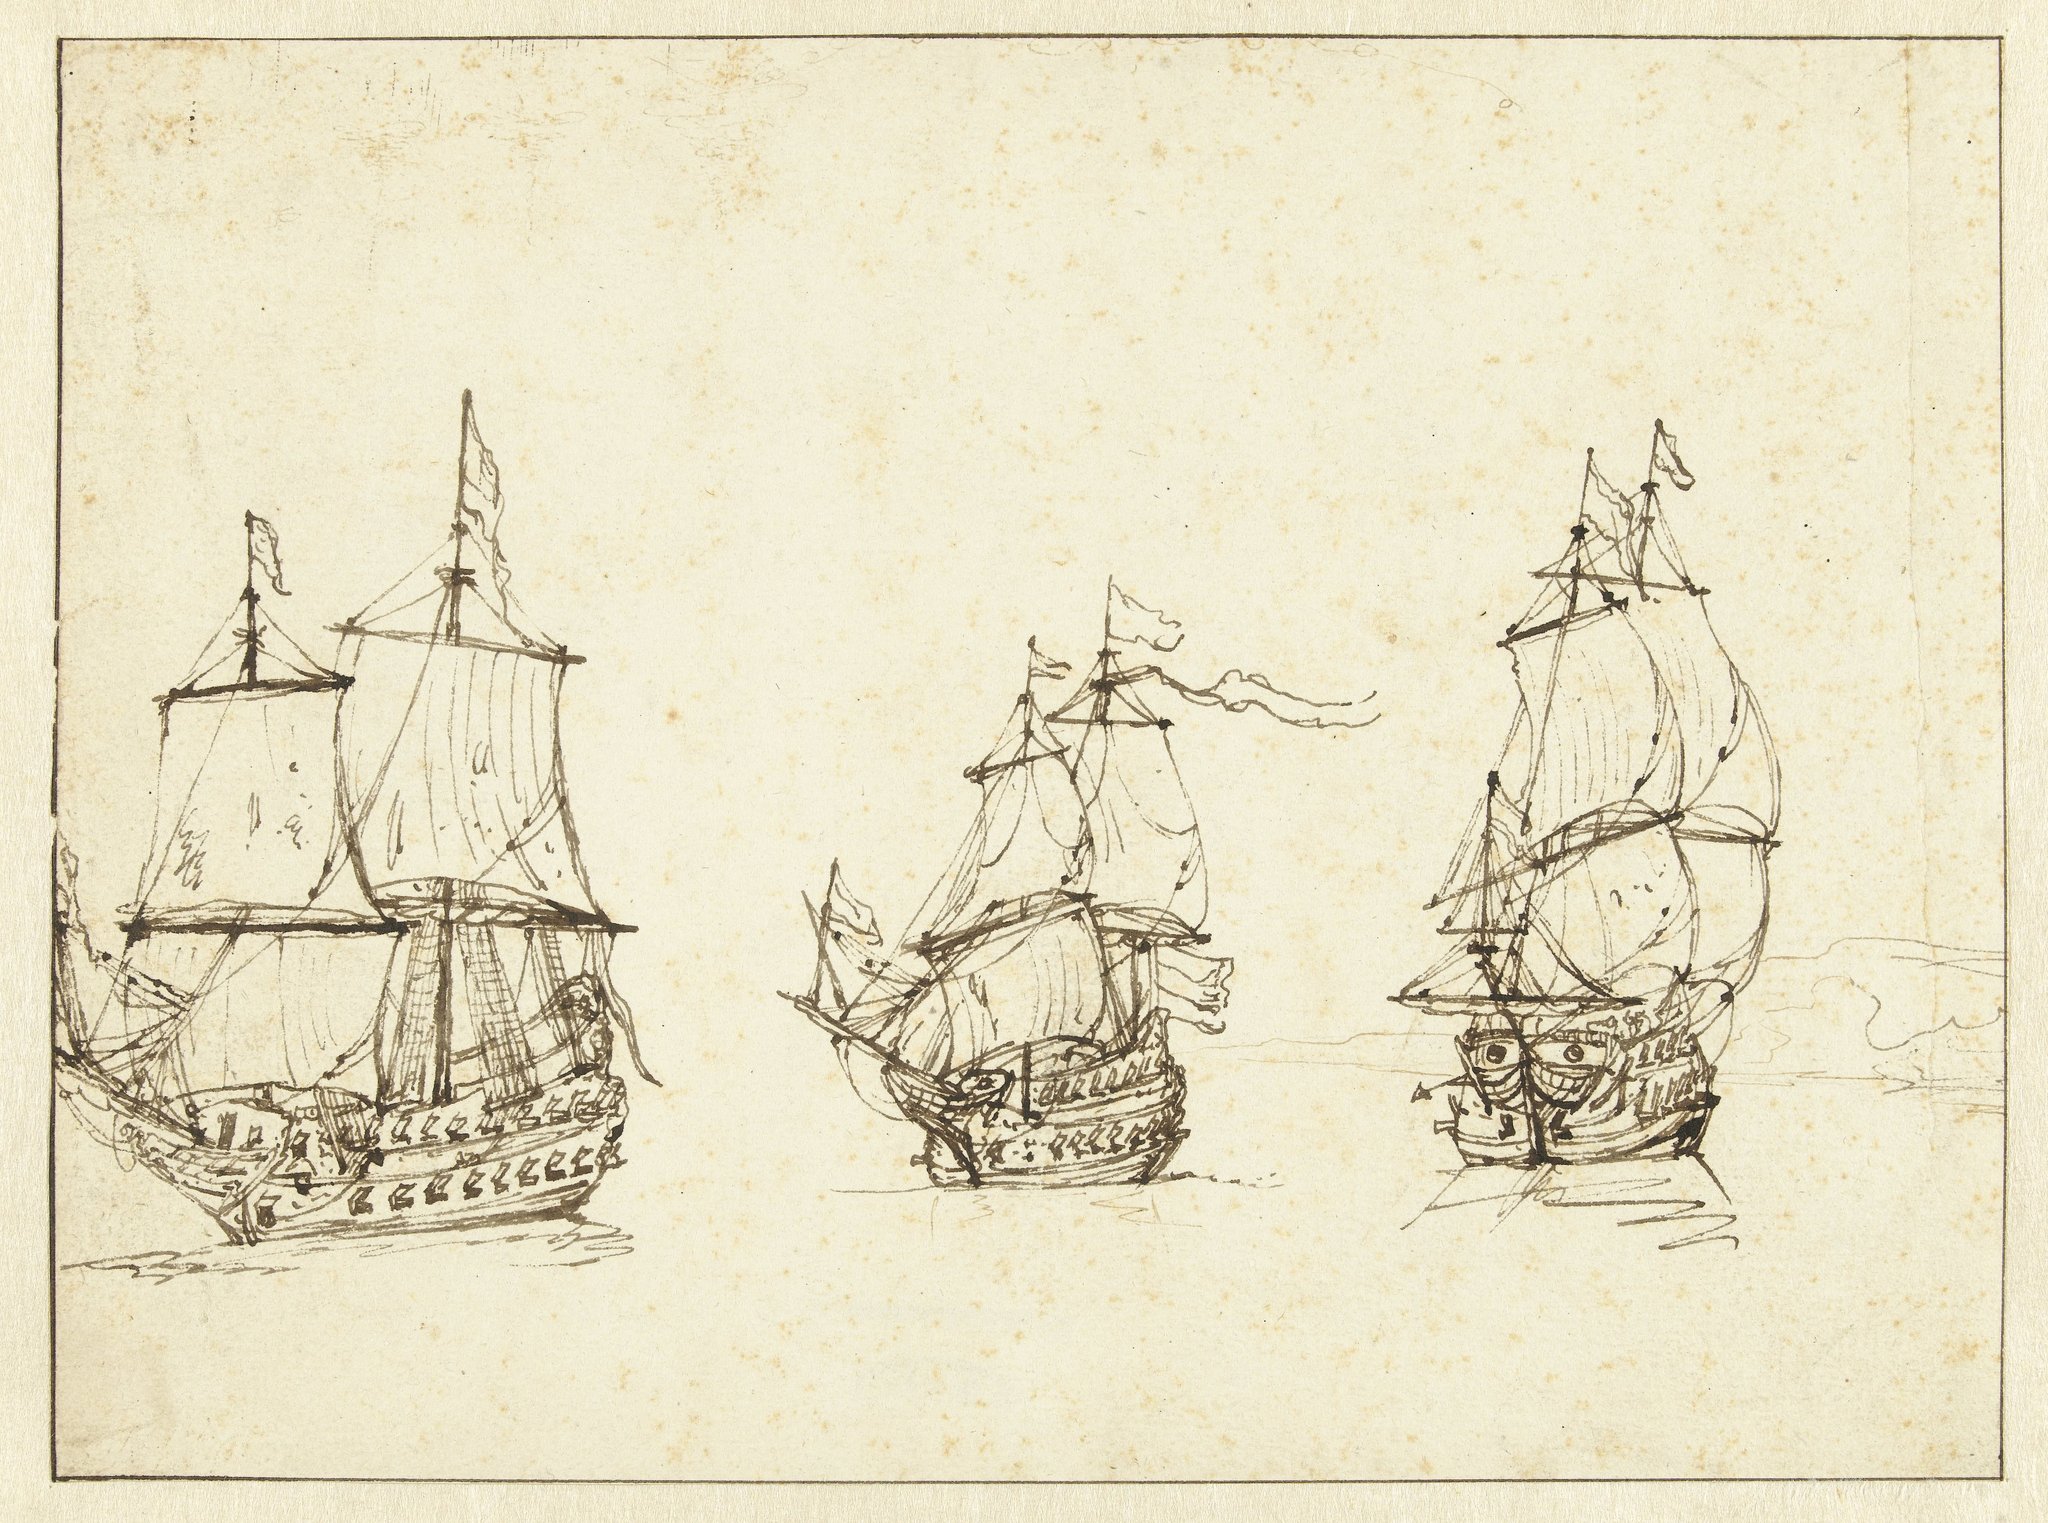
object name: drawing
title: Drie oorlogsschepen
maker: Anonymous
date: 1600-1699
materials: ink, paper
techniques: pen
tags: sailing-ship, sailing-boat, navy (+ sailing-ships)